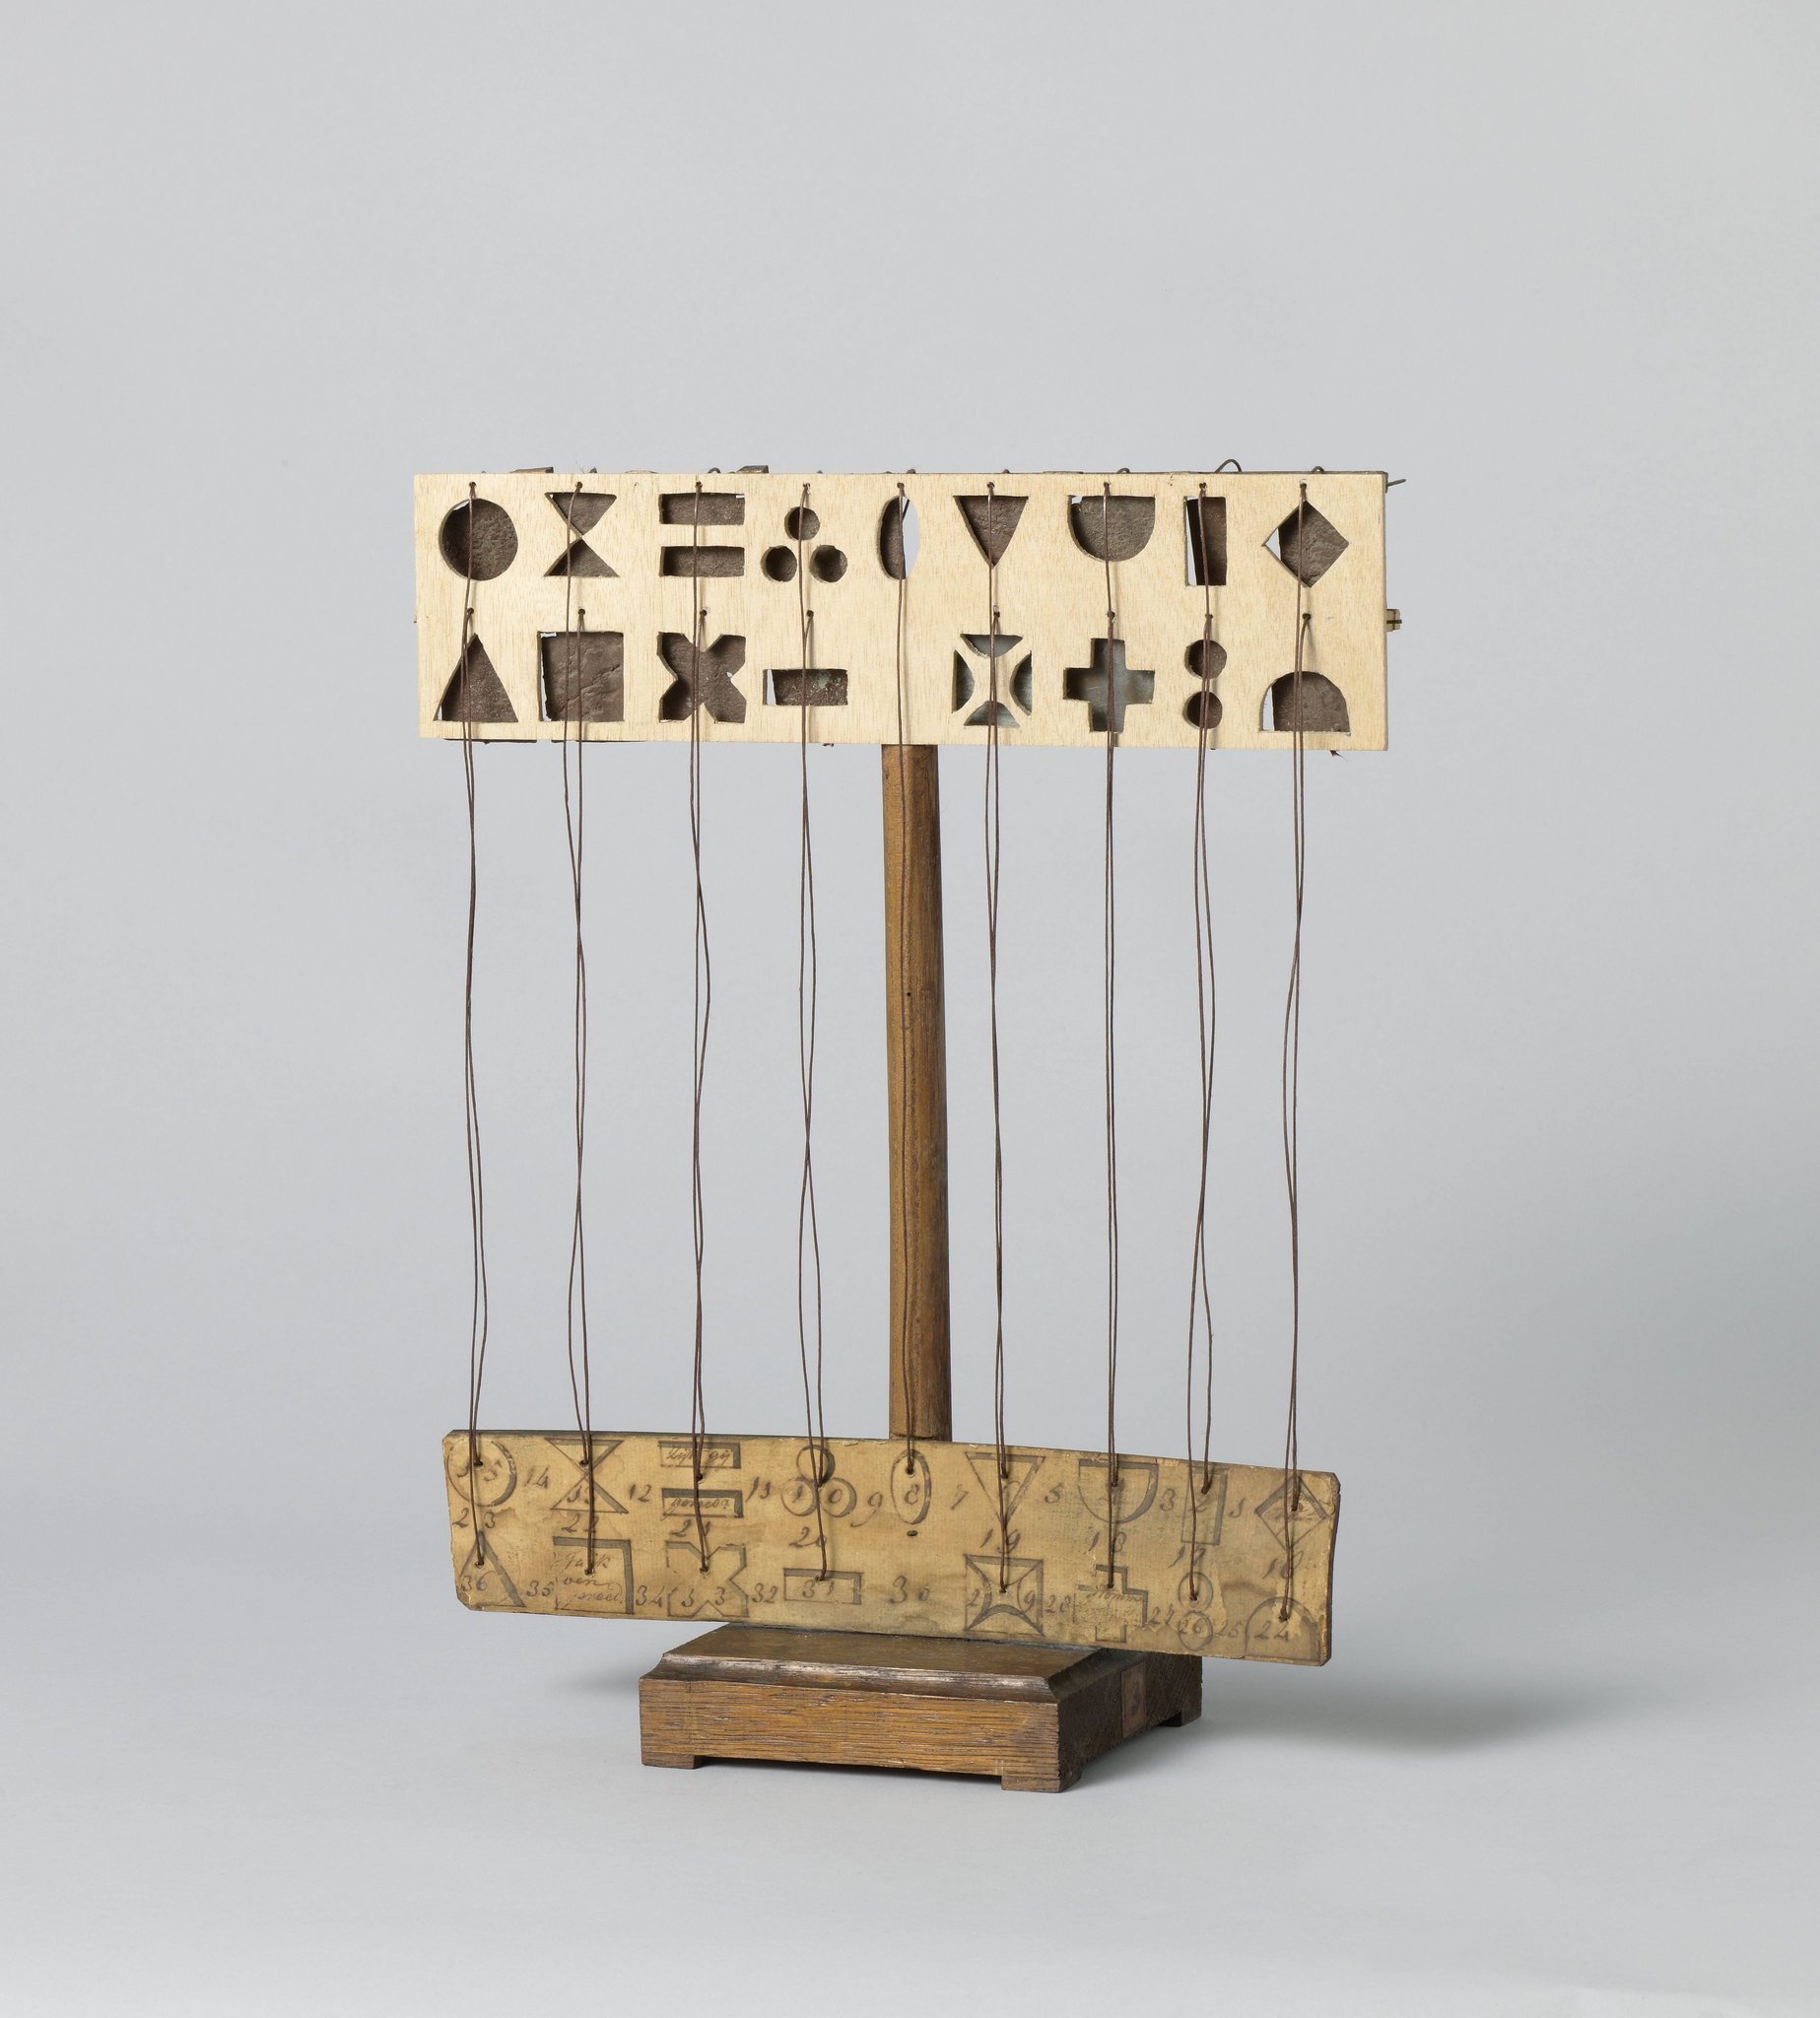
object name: instruction model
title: Model of an Optical Telegraph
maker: Anonymous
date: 1795-1800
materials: iron, lead, paper, fiber, wood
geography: netherlands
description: Model van een optische (licht) telegraaf op een houten voet, in zeer slechte staat. Boven aan een mast is een houten projector-bord gehangen met zeventien uitgezaagde geometrische figuren in twee rijen. Dezelfde figuren zijn op een met papier beplakt bedieningsbord beneden getekend. De uitgezaagde figuren boven zijn afgedekt met loden kleppen, die met touwtjes gaande door de corresponderende figuren beneden opgetild kunnen worden, zodat de figuur licht doorlaat. Op het papier beneden worden zes en dertig figuur-combinaties aangegeven. Vier dienstseinen zijn in het Nederlands toegelicht. Aan de voet is een etiket met het nummer 3 aangebracht.